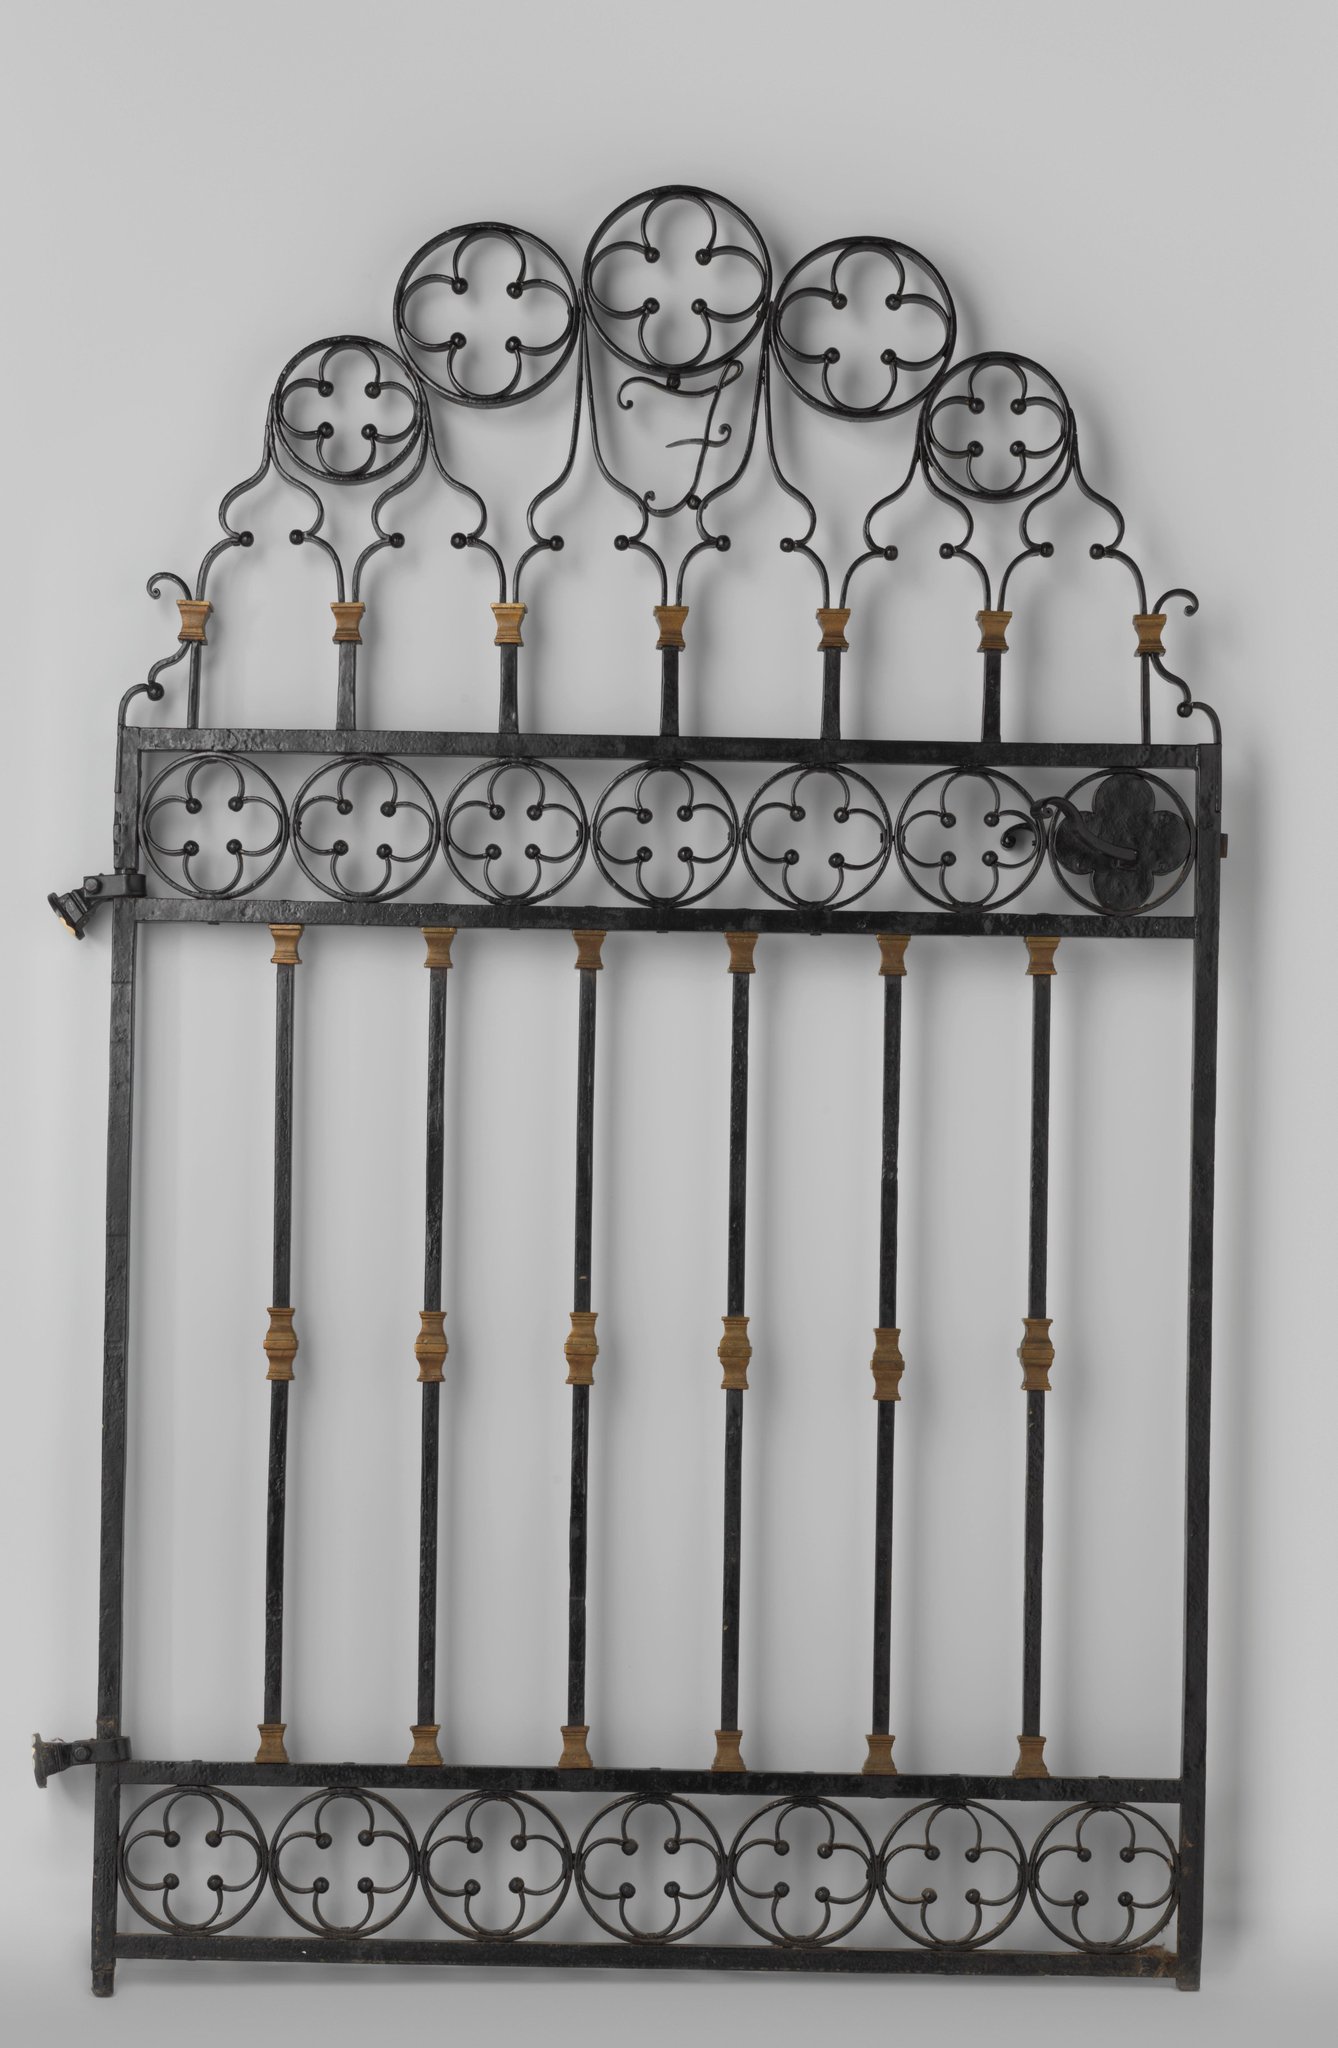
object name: hekdeur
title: Hekdeur met spitsboogbekroningen en de letter F., uit verz. Mannheimer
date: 1800-1900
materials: copper, iron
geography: italy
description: Lage hekdeur. Met een plint en een fries dat versierd wordt met zeven rondjes waarin een vierpas. In het middenvak vierhoekige spijlen met boven, onder en in het midden vierhoekige geprofileerde verdikkingen. Het hek heeft een bekroning gevormd uit zes spitsbogen, waarboven vijf rondjes met vierpas. Onder het middelste rondje de letter (F). Ijzer, verdikkingen van koper.